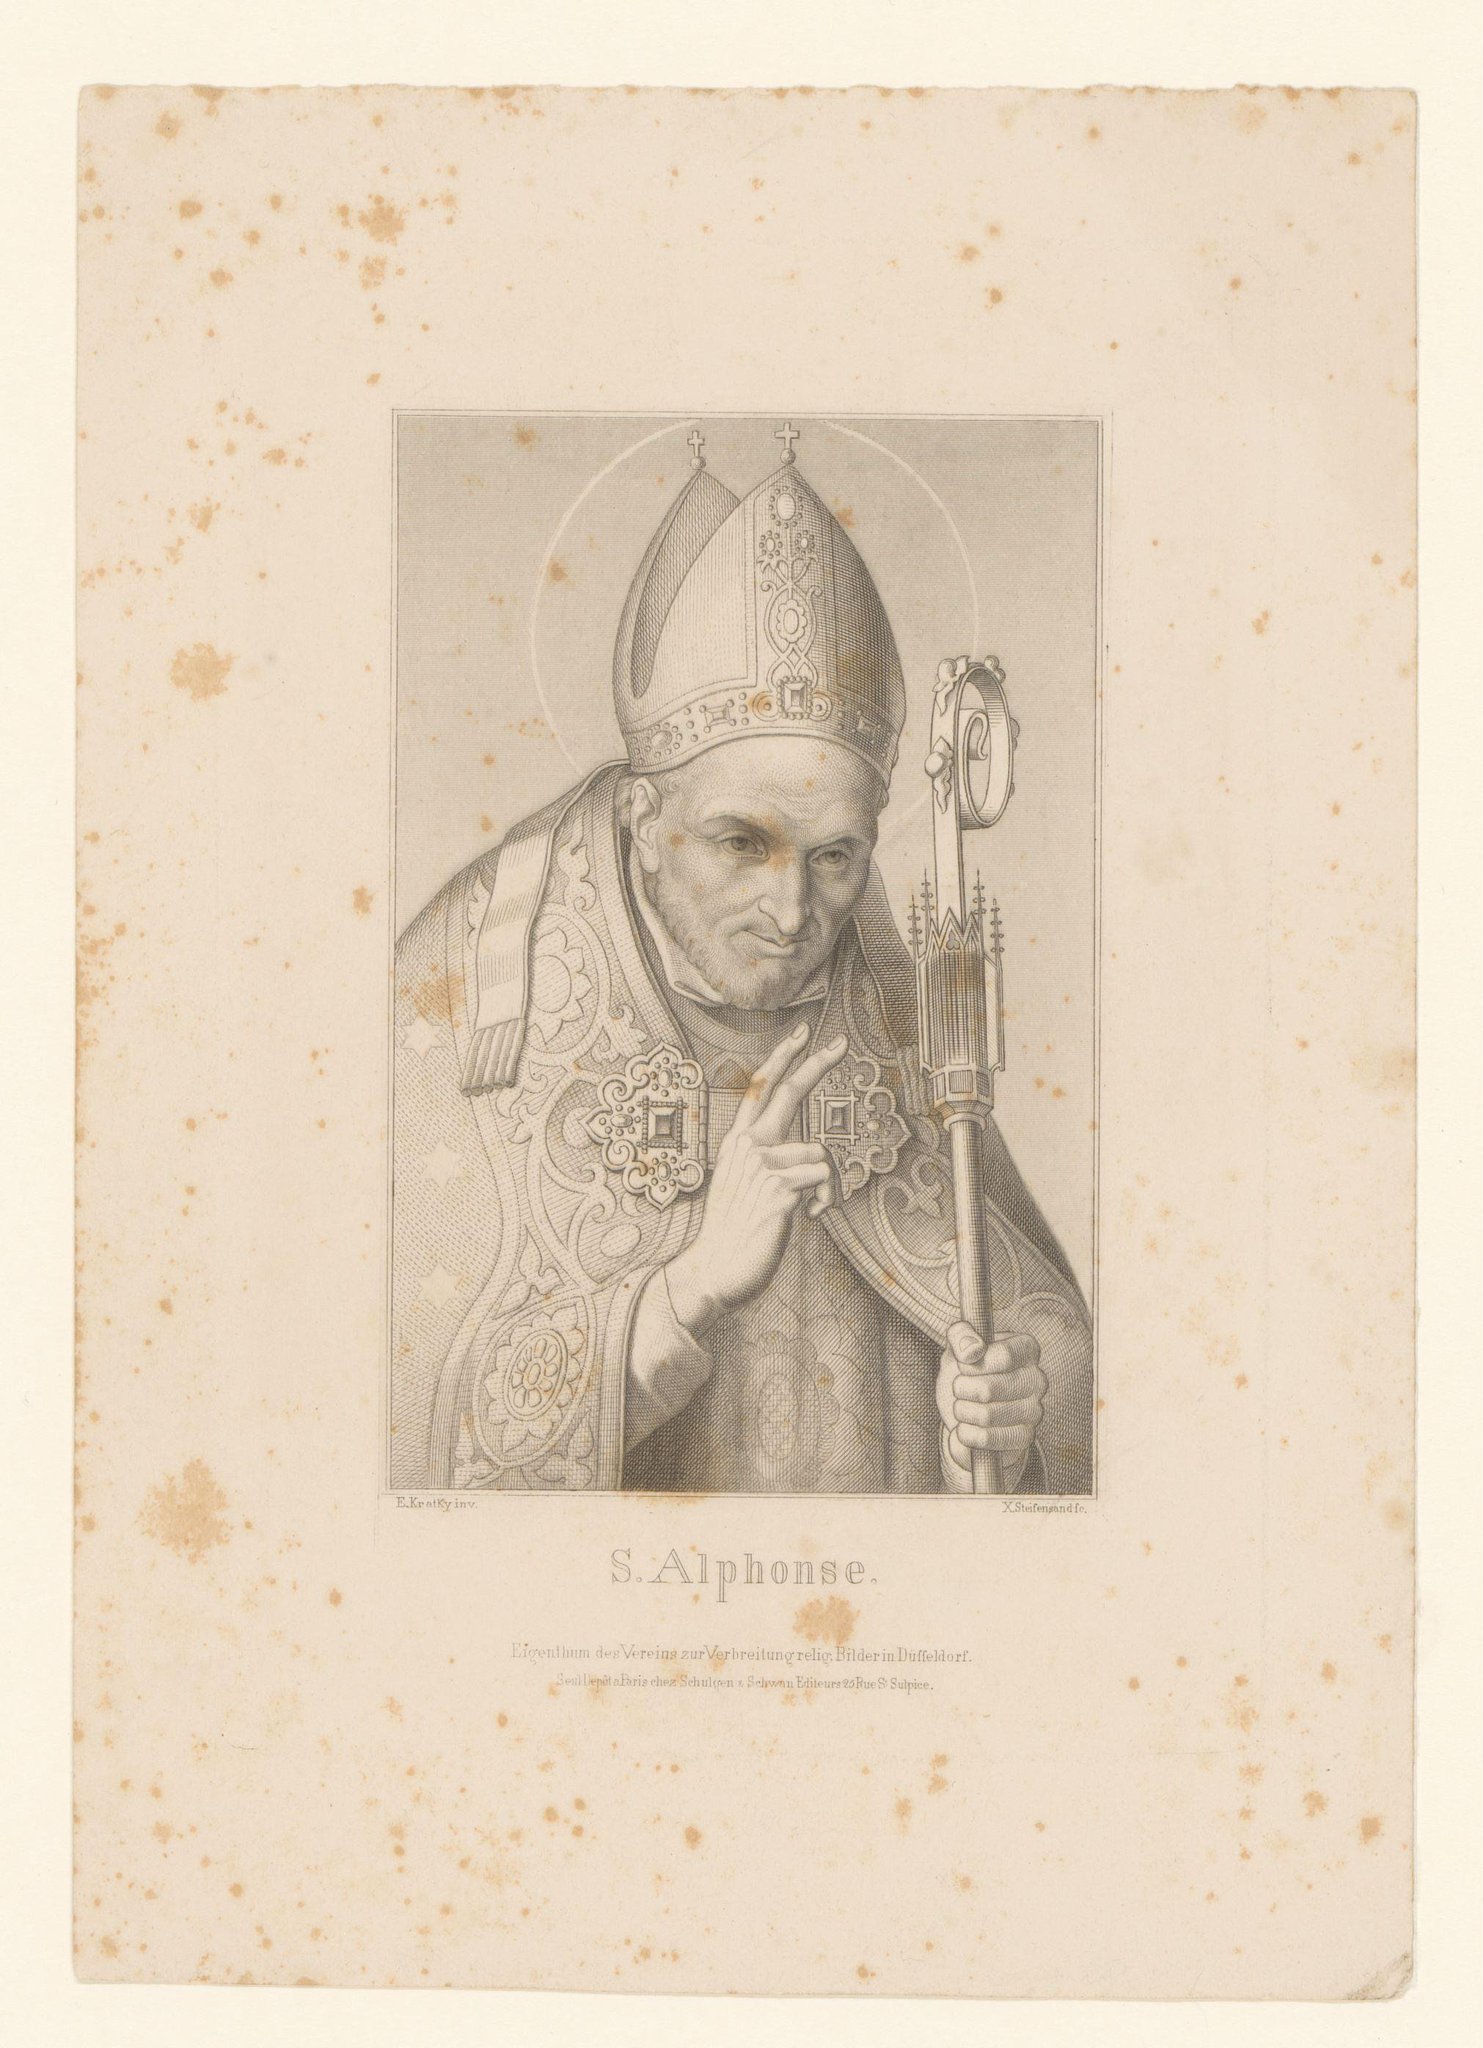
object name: print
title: Heilige Alfonso Maria de' Liguori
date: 1834-1876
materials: paper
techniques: engraving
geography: paris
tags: archbishop, bishop, etc. (roman catholic)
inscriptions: collector's mark: Lugt 2228